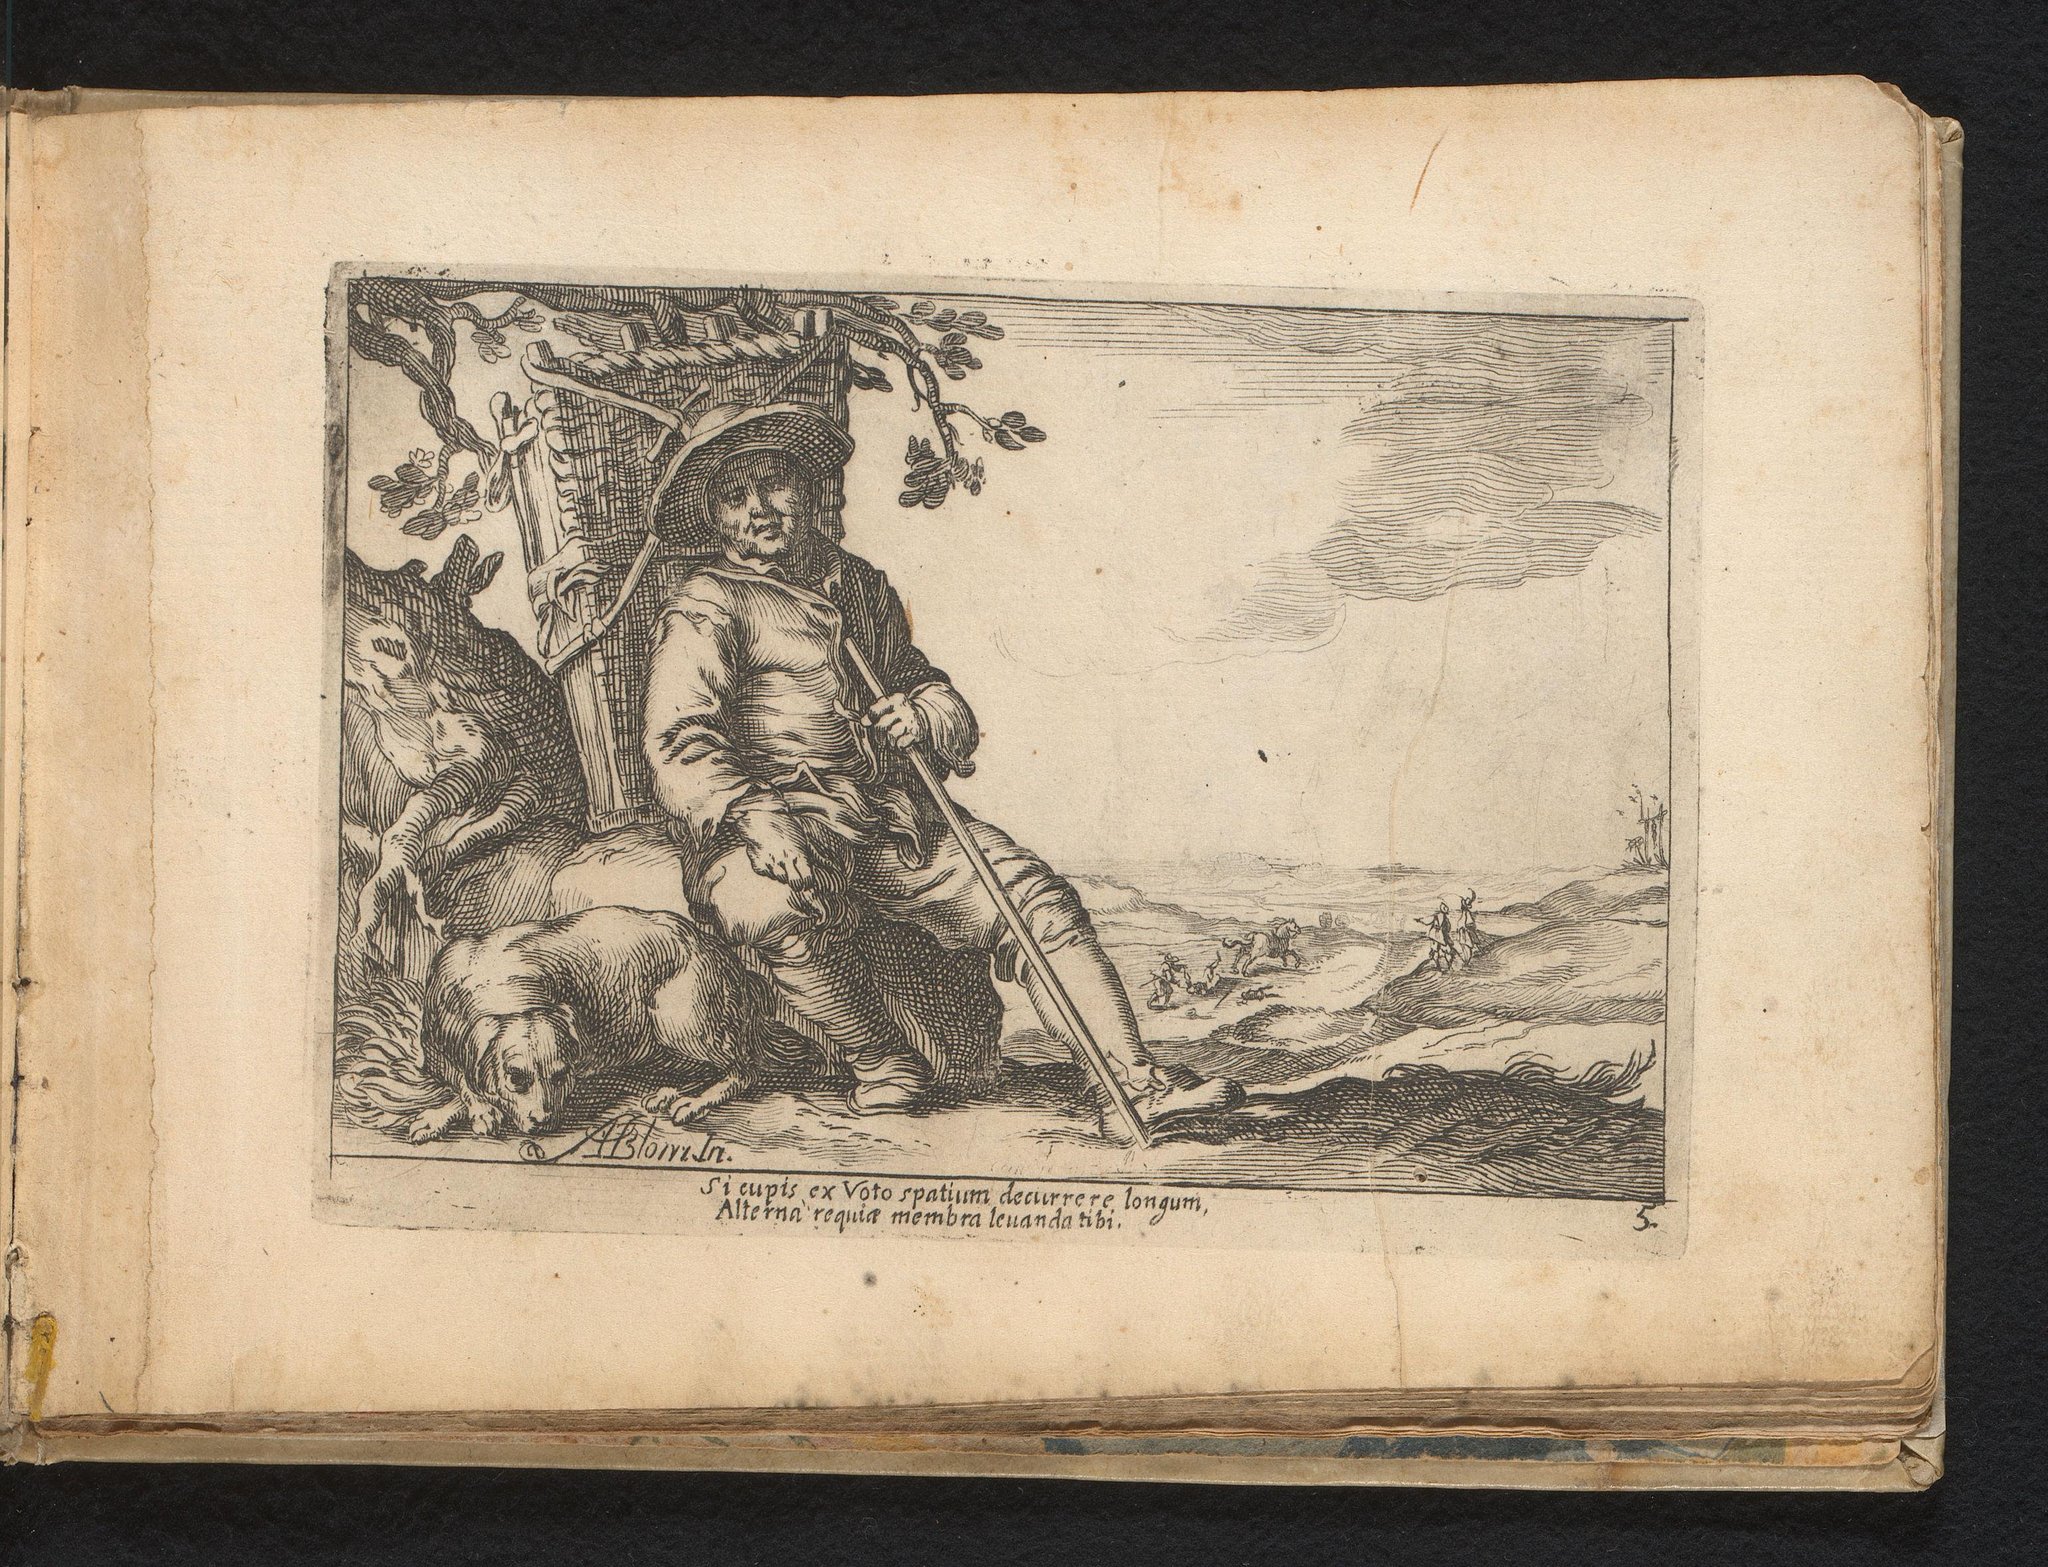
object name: print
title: Een rustende marskramer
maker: Anonymous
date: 1629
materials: ink, paper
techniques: engraving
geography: utrecht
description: Een marskramer zit tegen een boom geleund uit te rusten. Naast hem ligt een hond. Met tweeregelig vers in het Latijn in ondermarge. Het betreft de serie getiteld: Otia delectant faciuntq [...]. Kalfsleren band met opschrift en decoratieve kaderlijnen in pen in bruin. Voorin en achterin vier schutbladen van velijn.